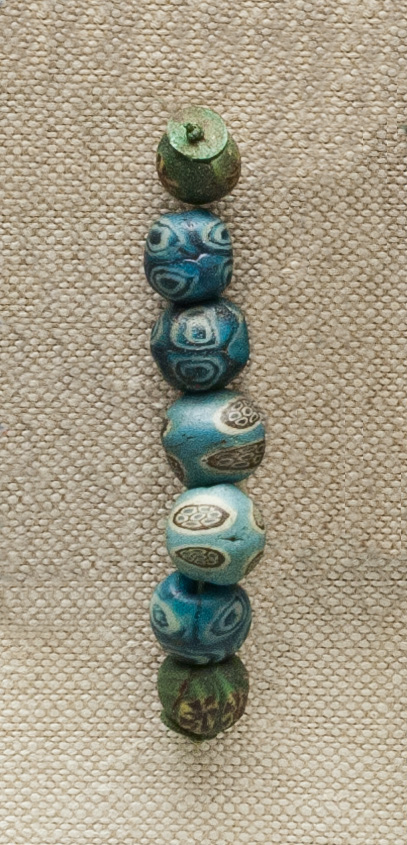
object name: necklace, bead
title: String of 7 Eyed Beads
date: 1-1000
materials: glass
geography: egypt